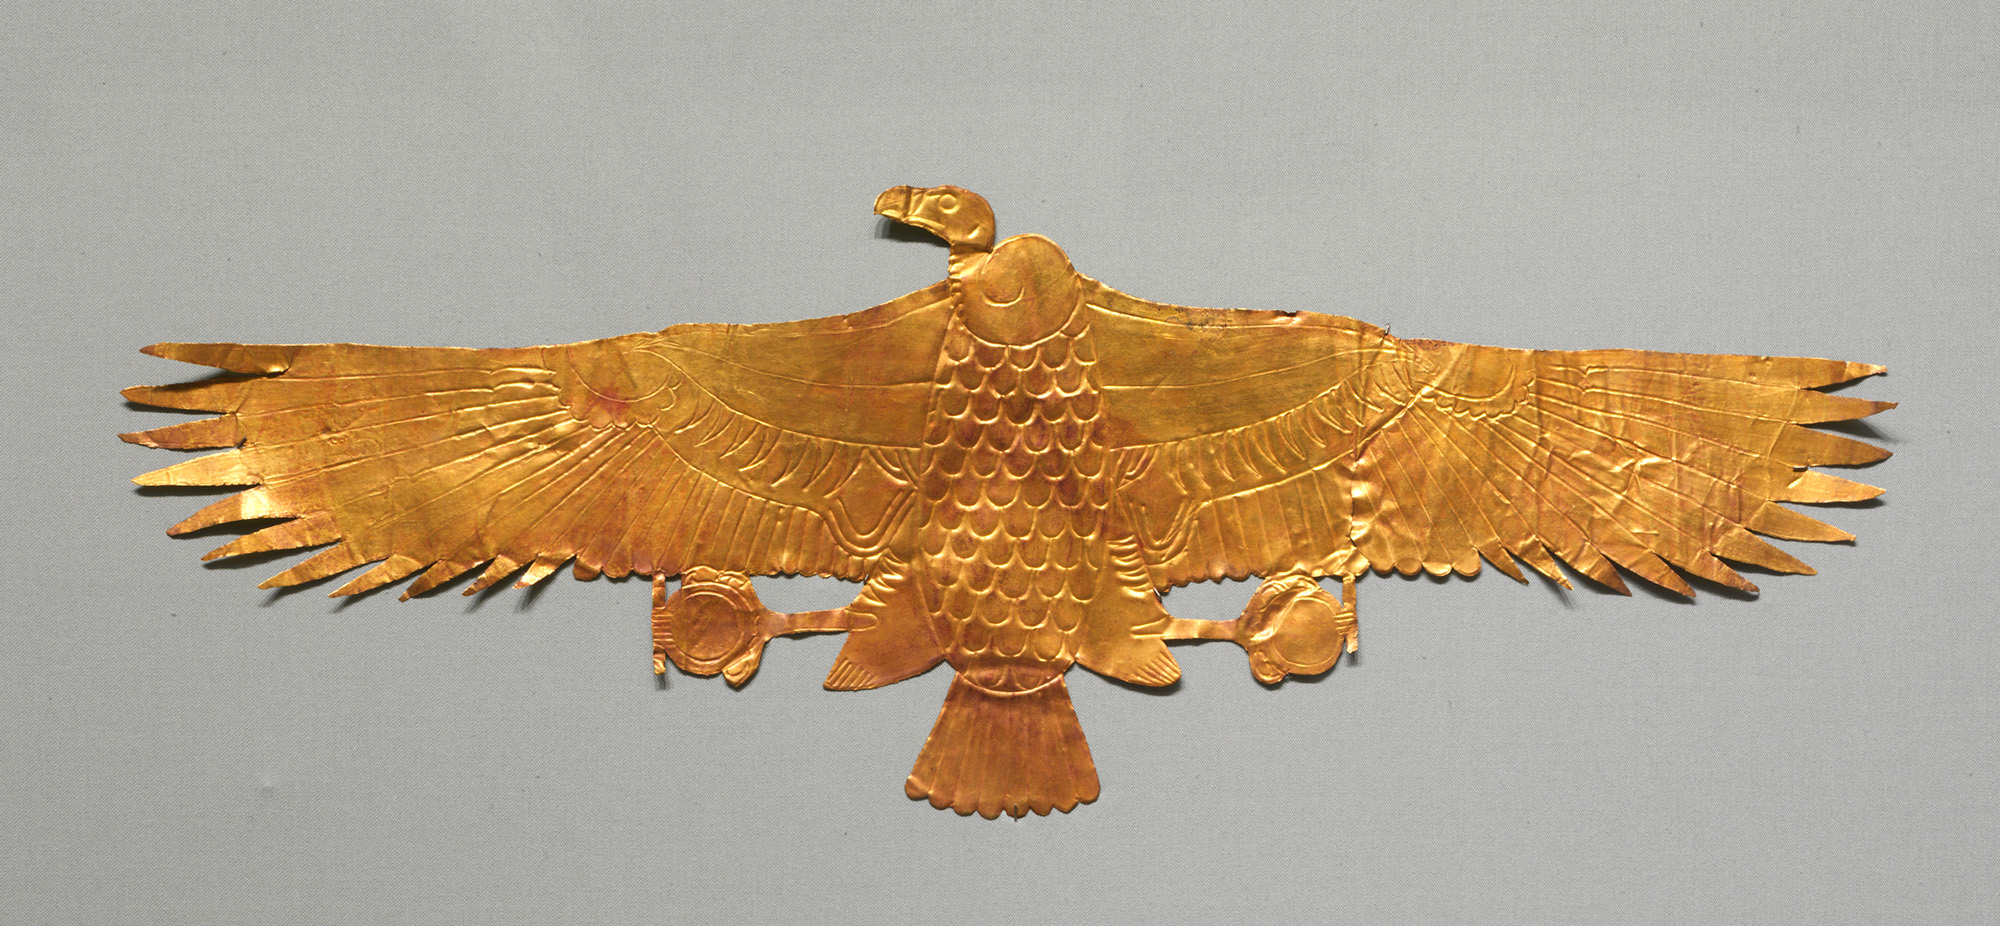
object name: funerary pectoral in the shape of a vulture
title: Vulture Pectoral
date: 1479-1425 BCE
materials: gold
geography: egypt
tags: birds